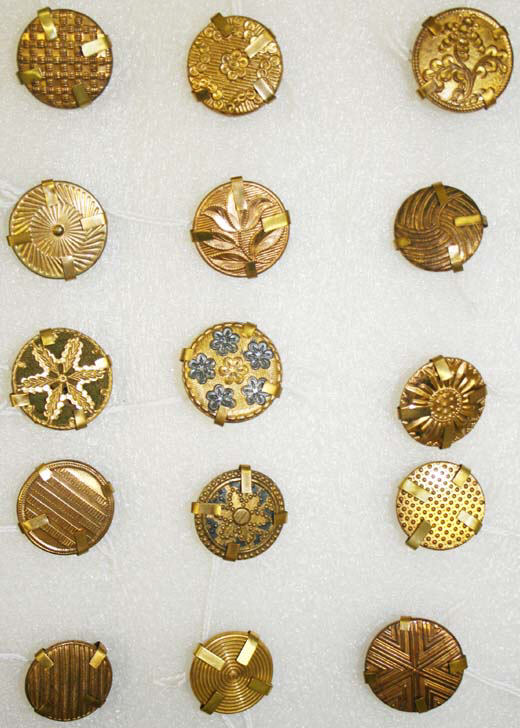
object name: button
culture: french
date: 1780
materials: bone, metal, wood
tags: flowers